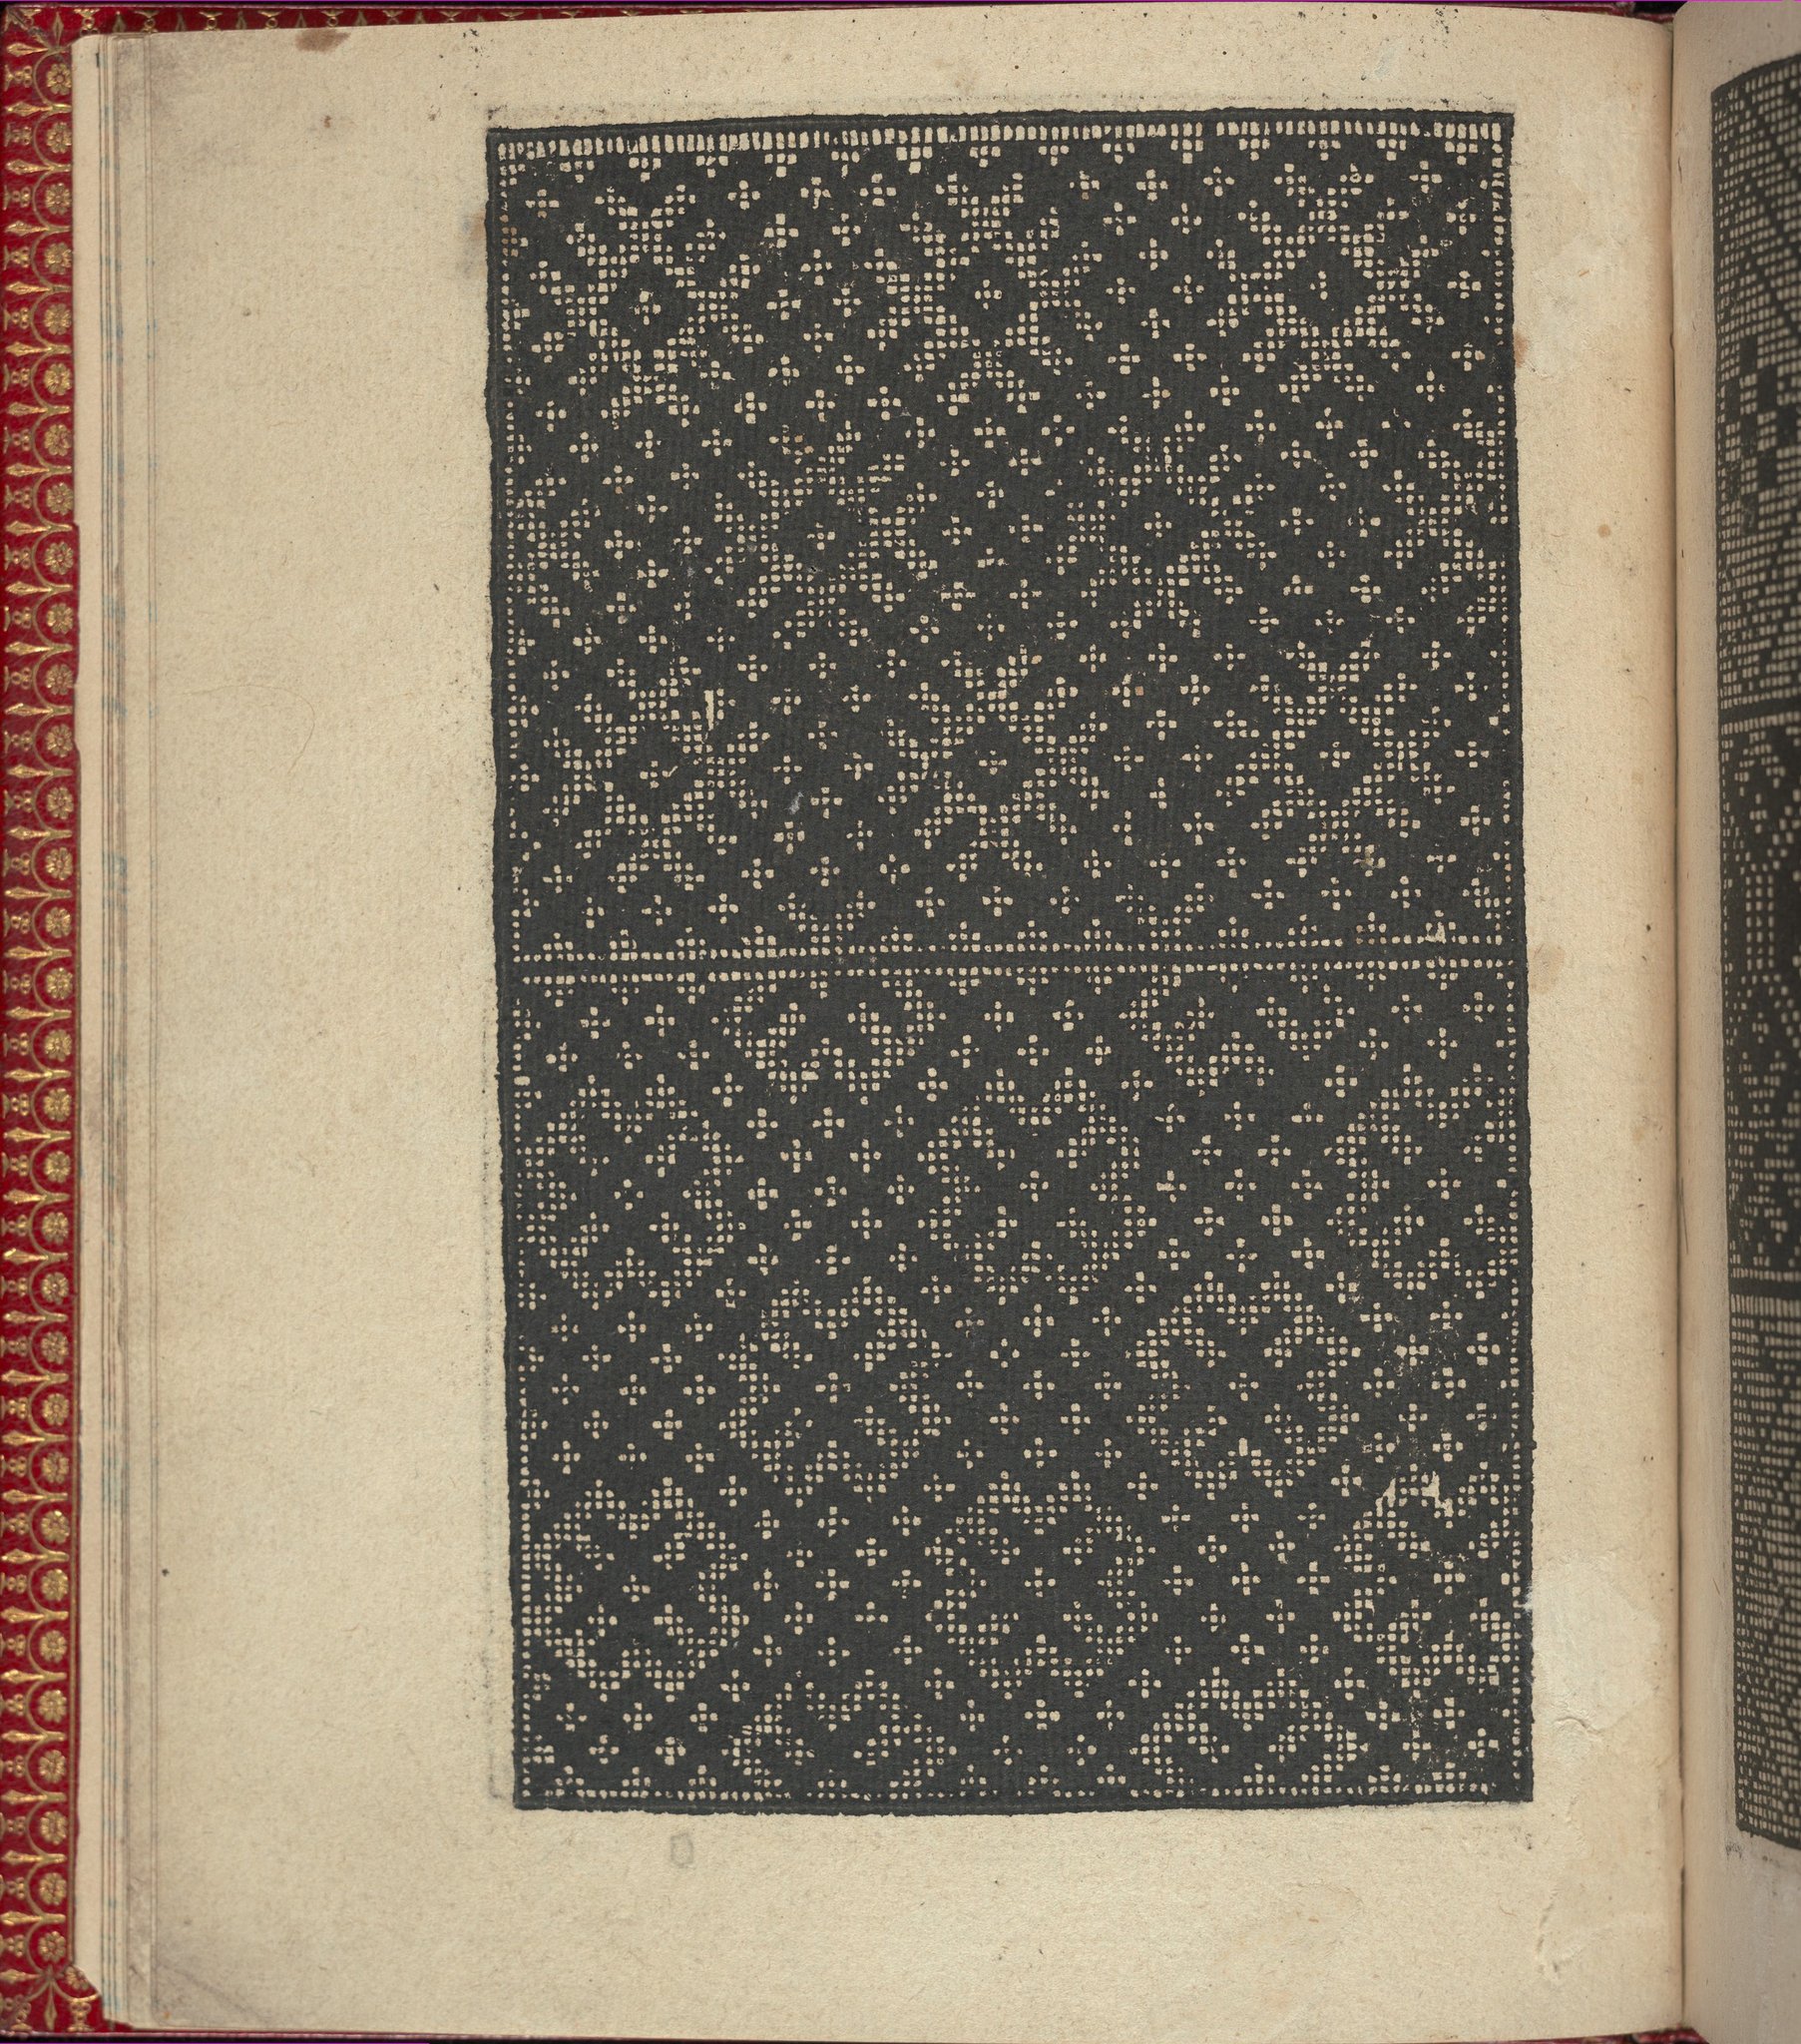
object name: book print ornament architecture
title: Ce est ung tractat de la noble art de leguille ascavoir ouvraiges de spaigne... page 4 (verso)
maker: willem vosterman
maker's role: printer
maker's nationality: netherlandish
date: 1527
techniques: woodcut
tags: ornament